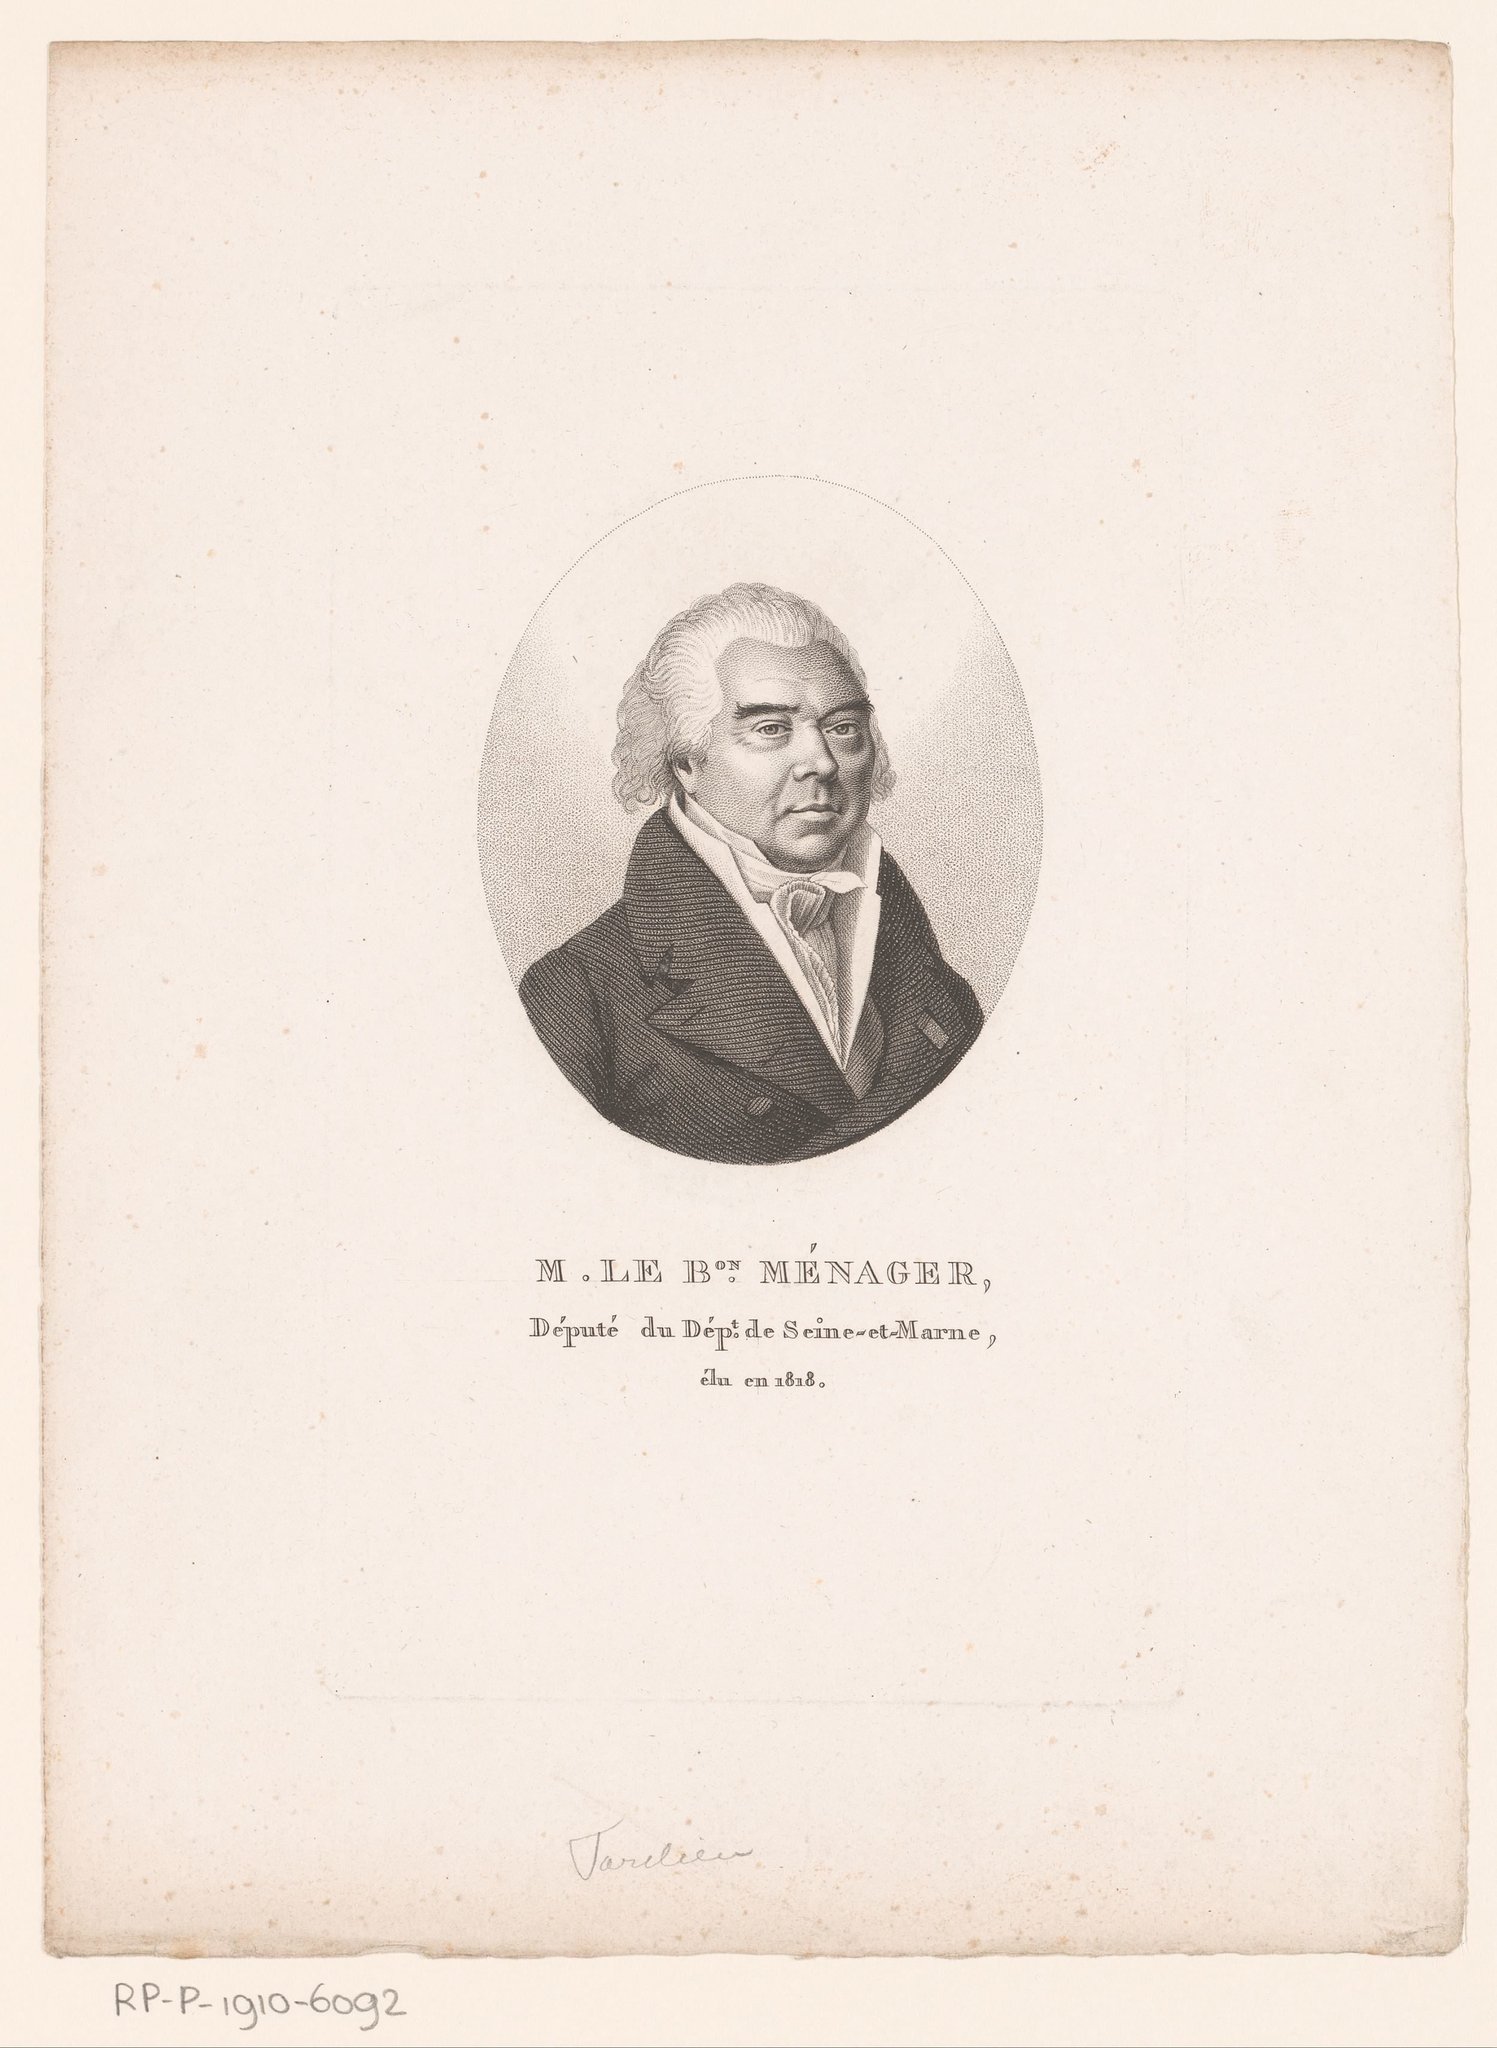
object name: print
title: Portret van Antoine Jean François Ménager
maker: ambroise tardieu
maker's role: print maker, printer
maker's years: 1788-1841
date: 1820-1821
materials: paper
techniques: engraving, roulette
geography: paris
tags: politician, historical persons, politician, e.g. party leader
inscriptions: collector's mark: Lugt 2228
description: Prent uit: Tardieu, Ambroise. Portraits des députés, écrivains et pairs constitutionnels, défenseurs invariables de la charte et de la loi des élections du 5 février 1817. Parijs: Tardieu, Ambroise, 1820-1821.